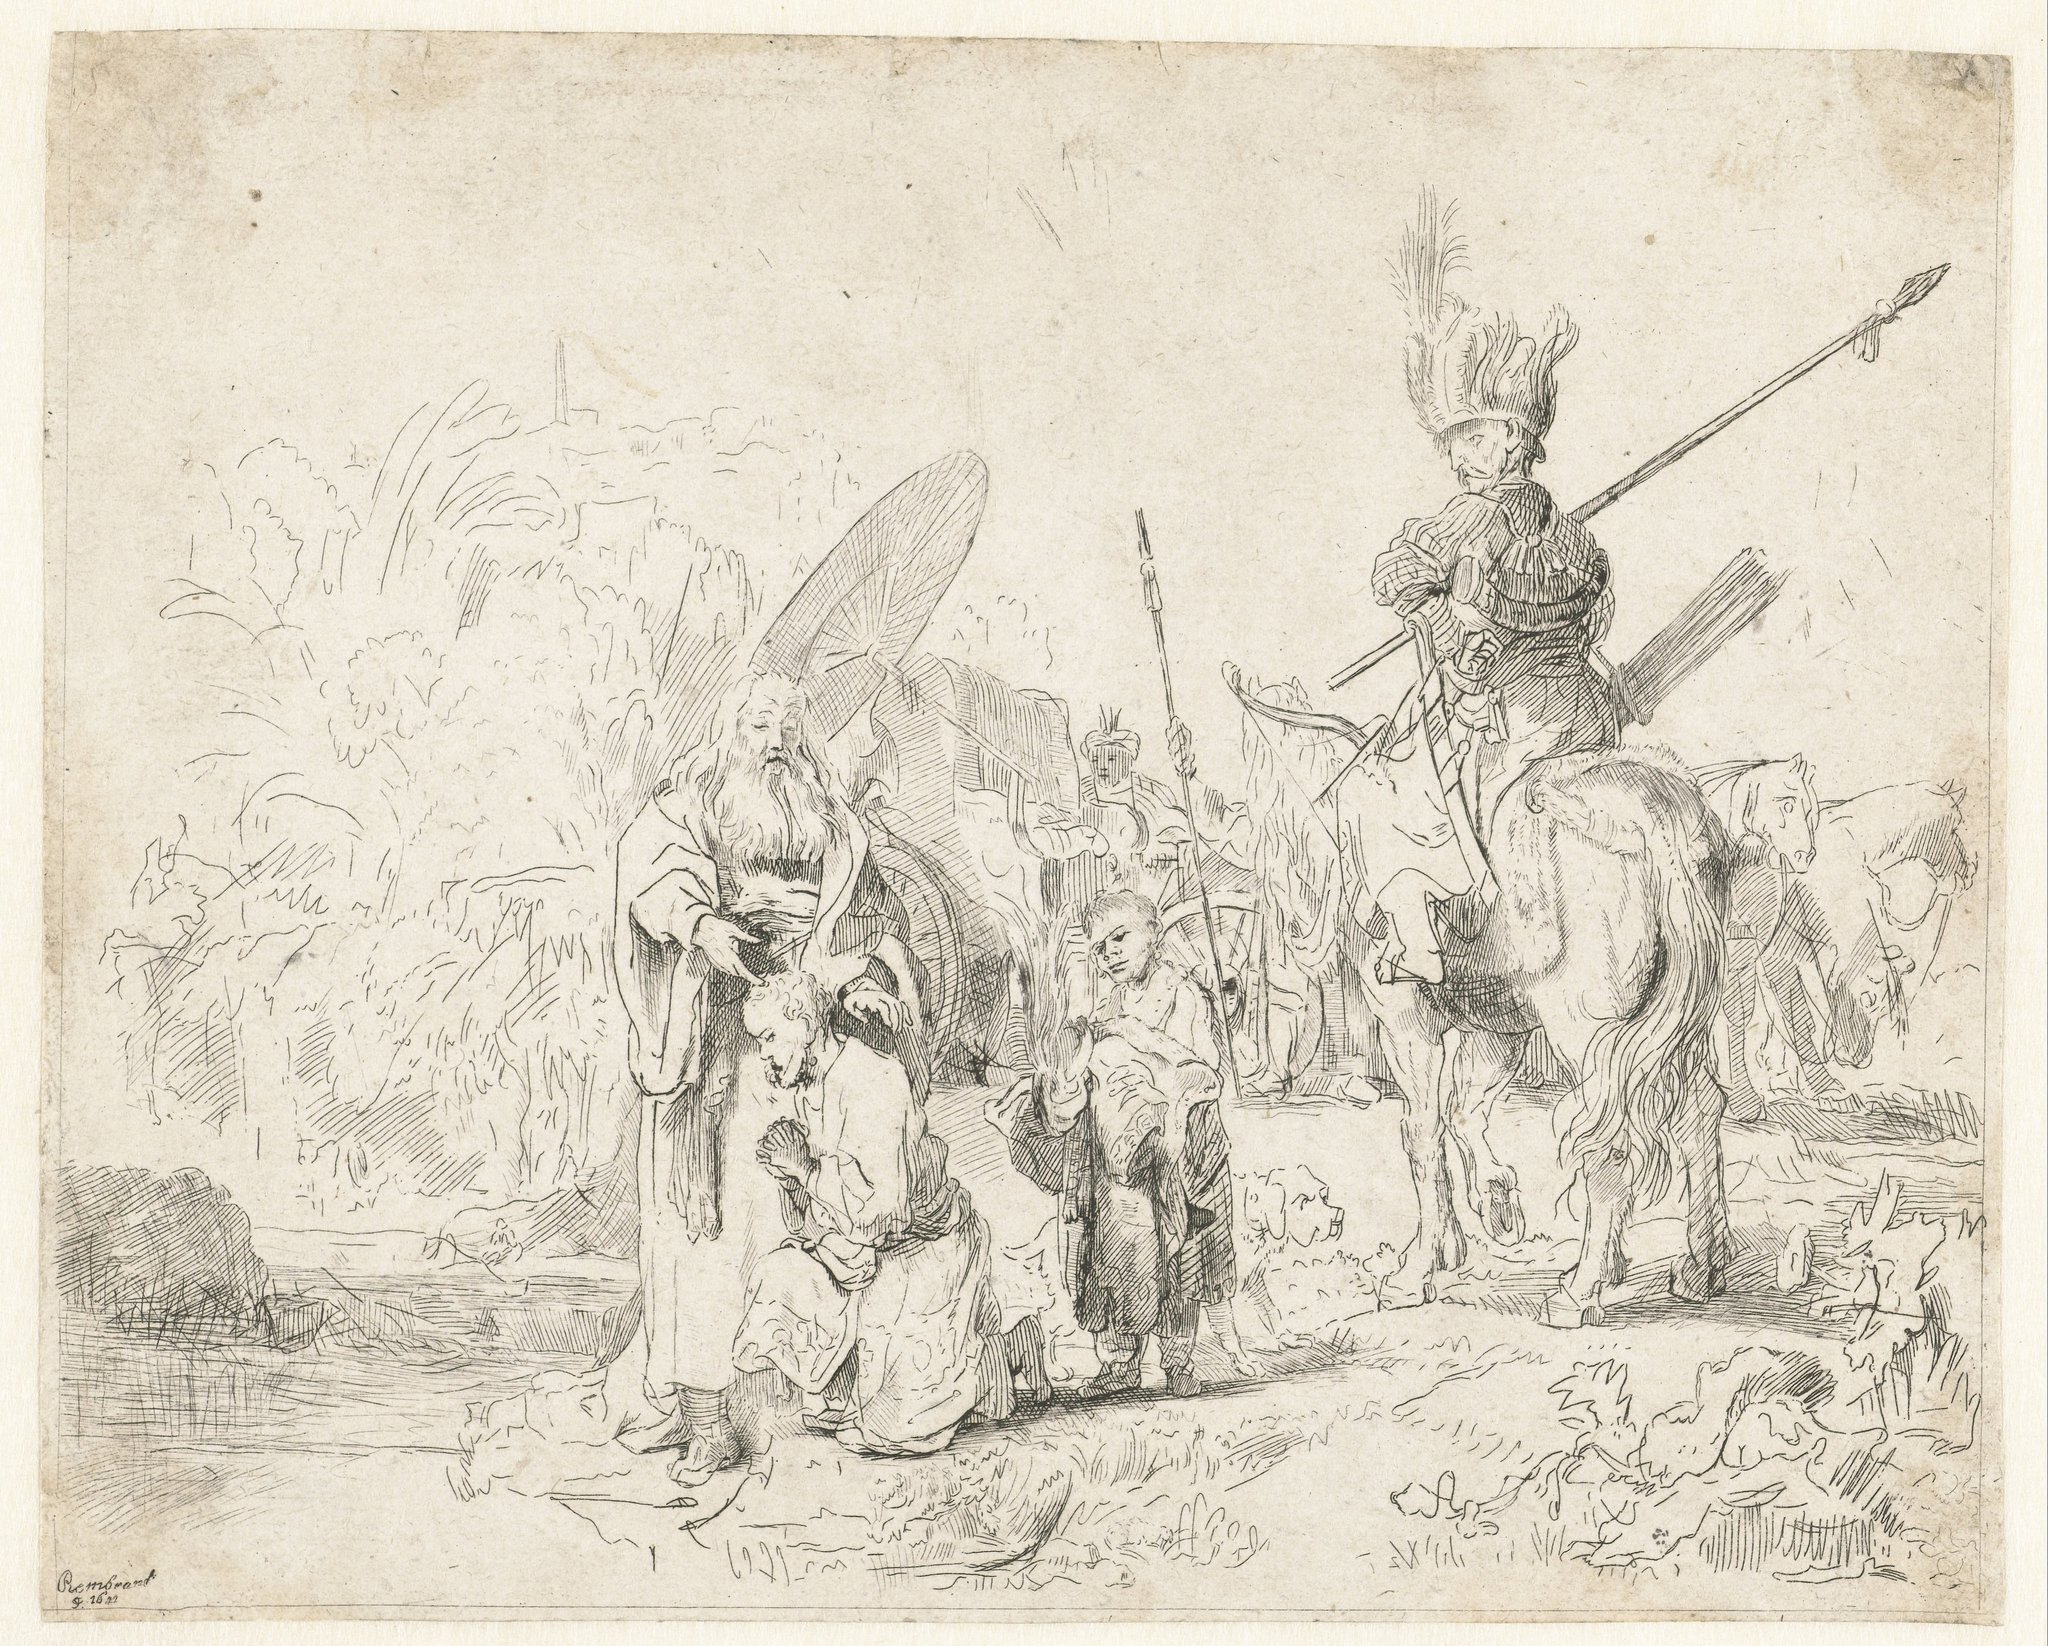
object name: print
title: The baptism of the eunuch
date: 1641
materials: paper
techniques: etching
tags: philip baptizes the eunuch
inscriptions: collector's mark: Lugt 2228, collector's mark: Lugt 2760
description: Spiegelbeeldige kopie naar de gelijknamige prent van Rembrandt.